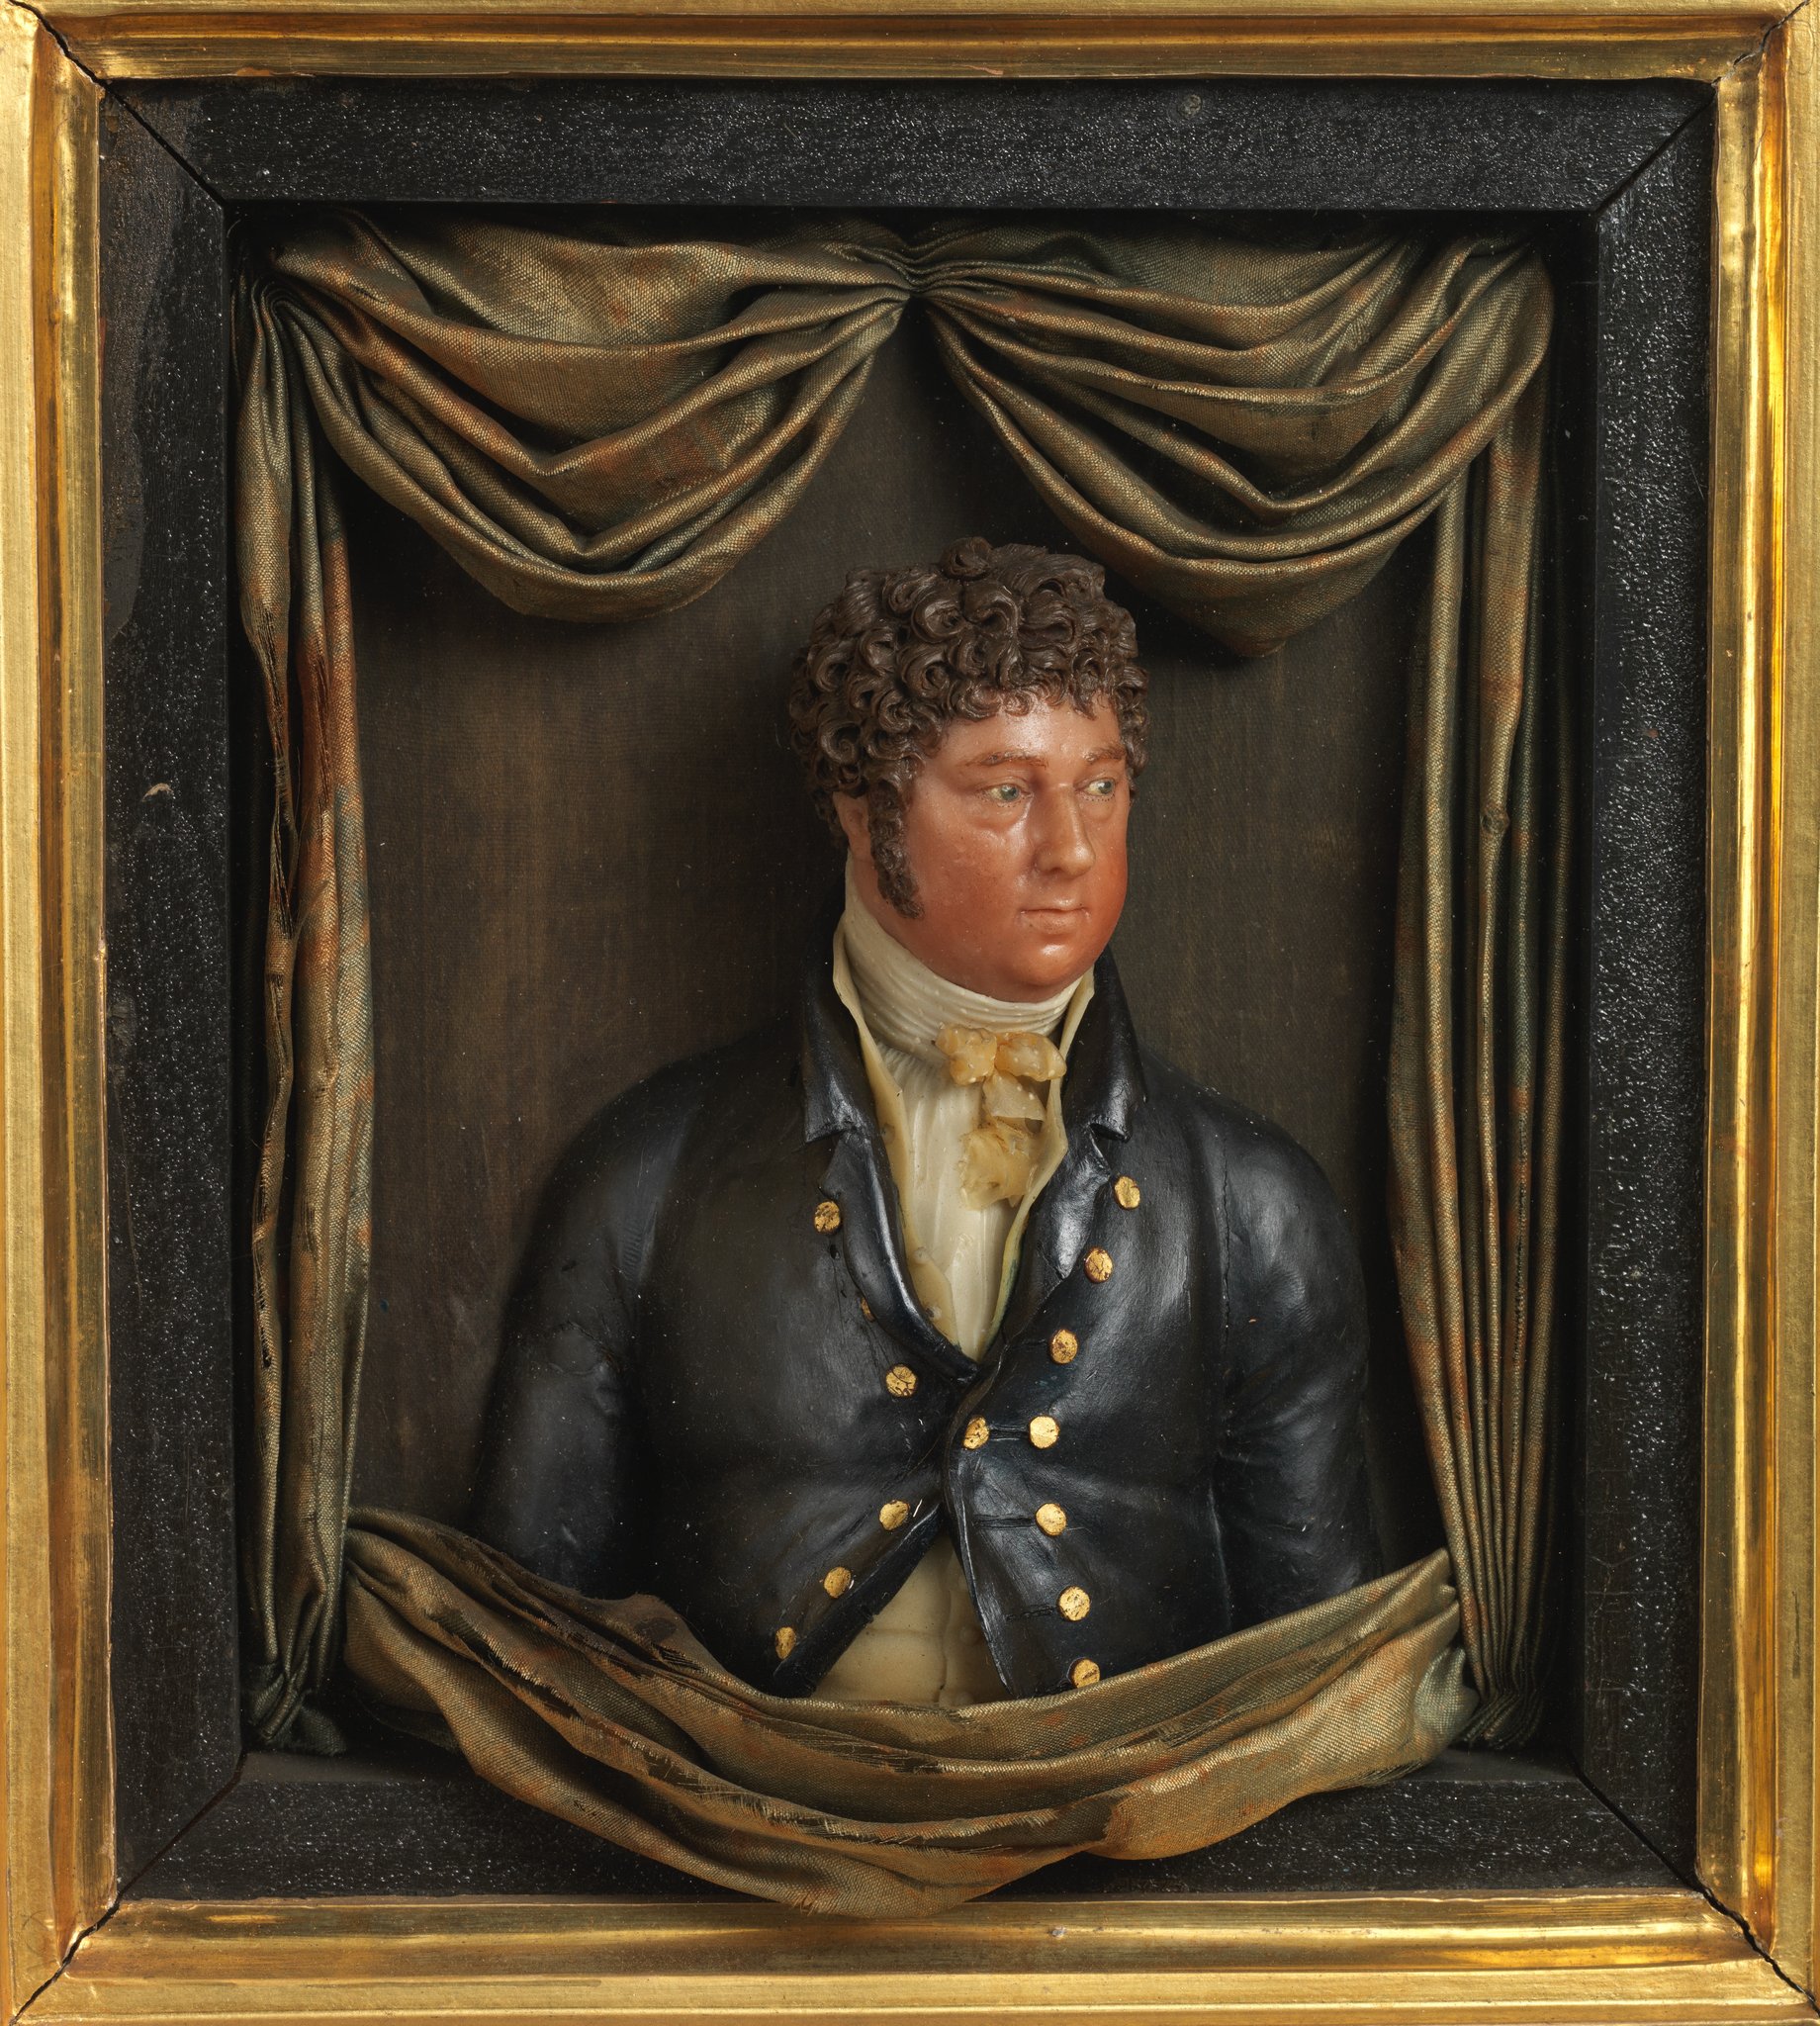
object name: relief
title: Portrait of a man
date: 1801-1833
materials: silk, wax, wood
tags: men,portraits